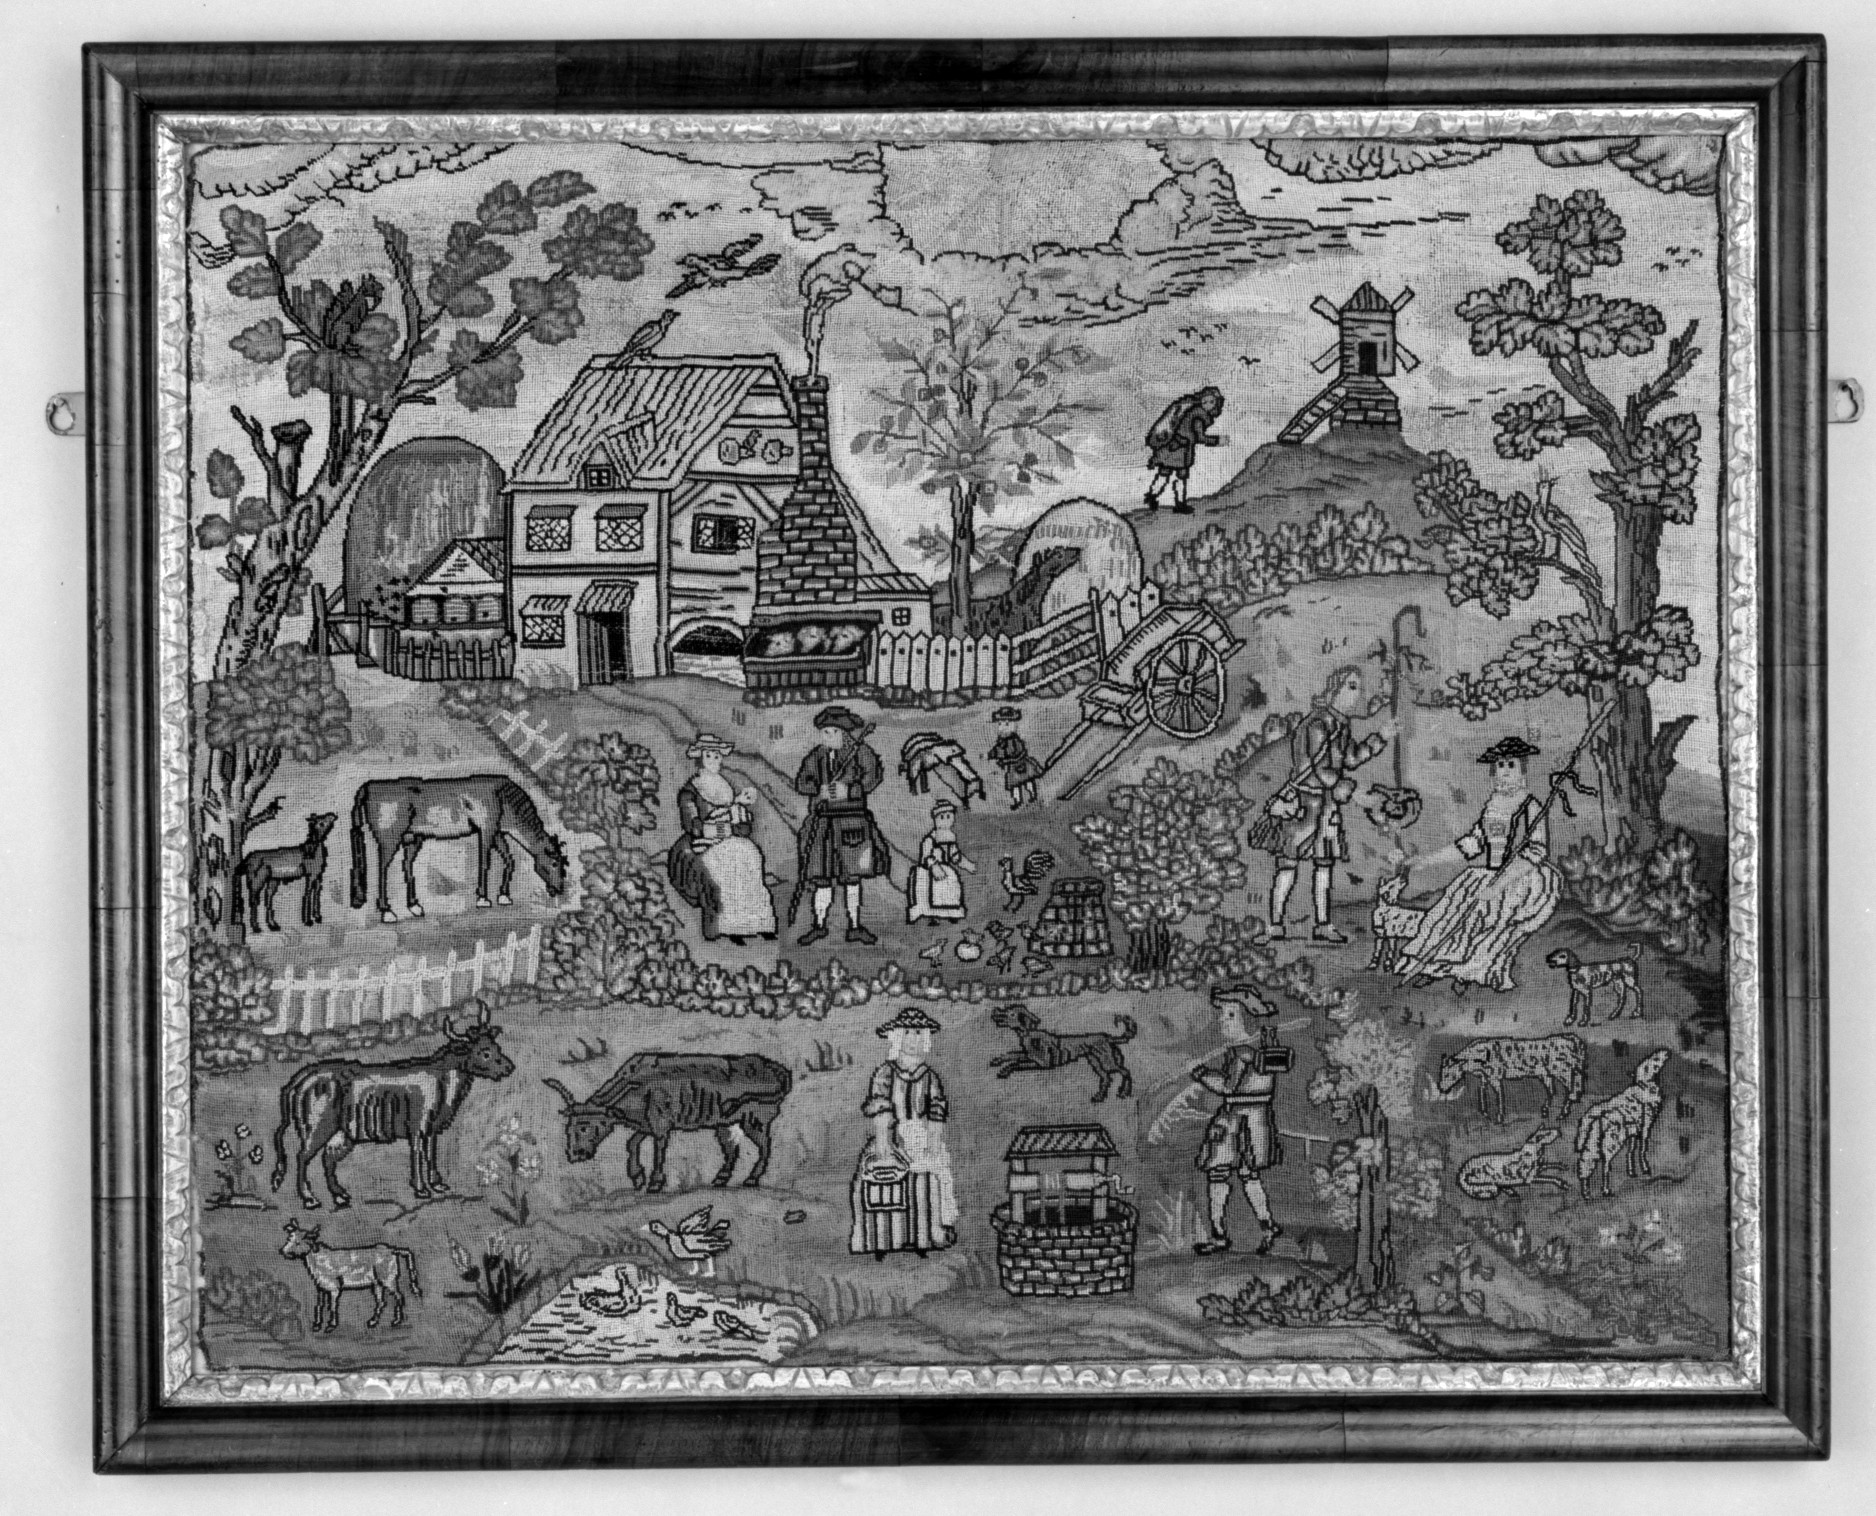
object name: embroidered picture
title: Embroidered picture with farmyard scene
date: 1701-1725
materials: canvas, gilt, silk, wood, wool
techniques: carving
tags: animals,houses,windmills,farms,men,women,cows,dogs,horses